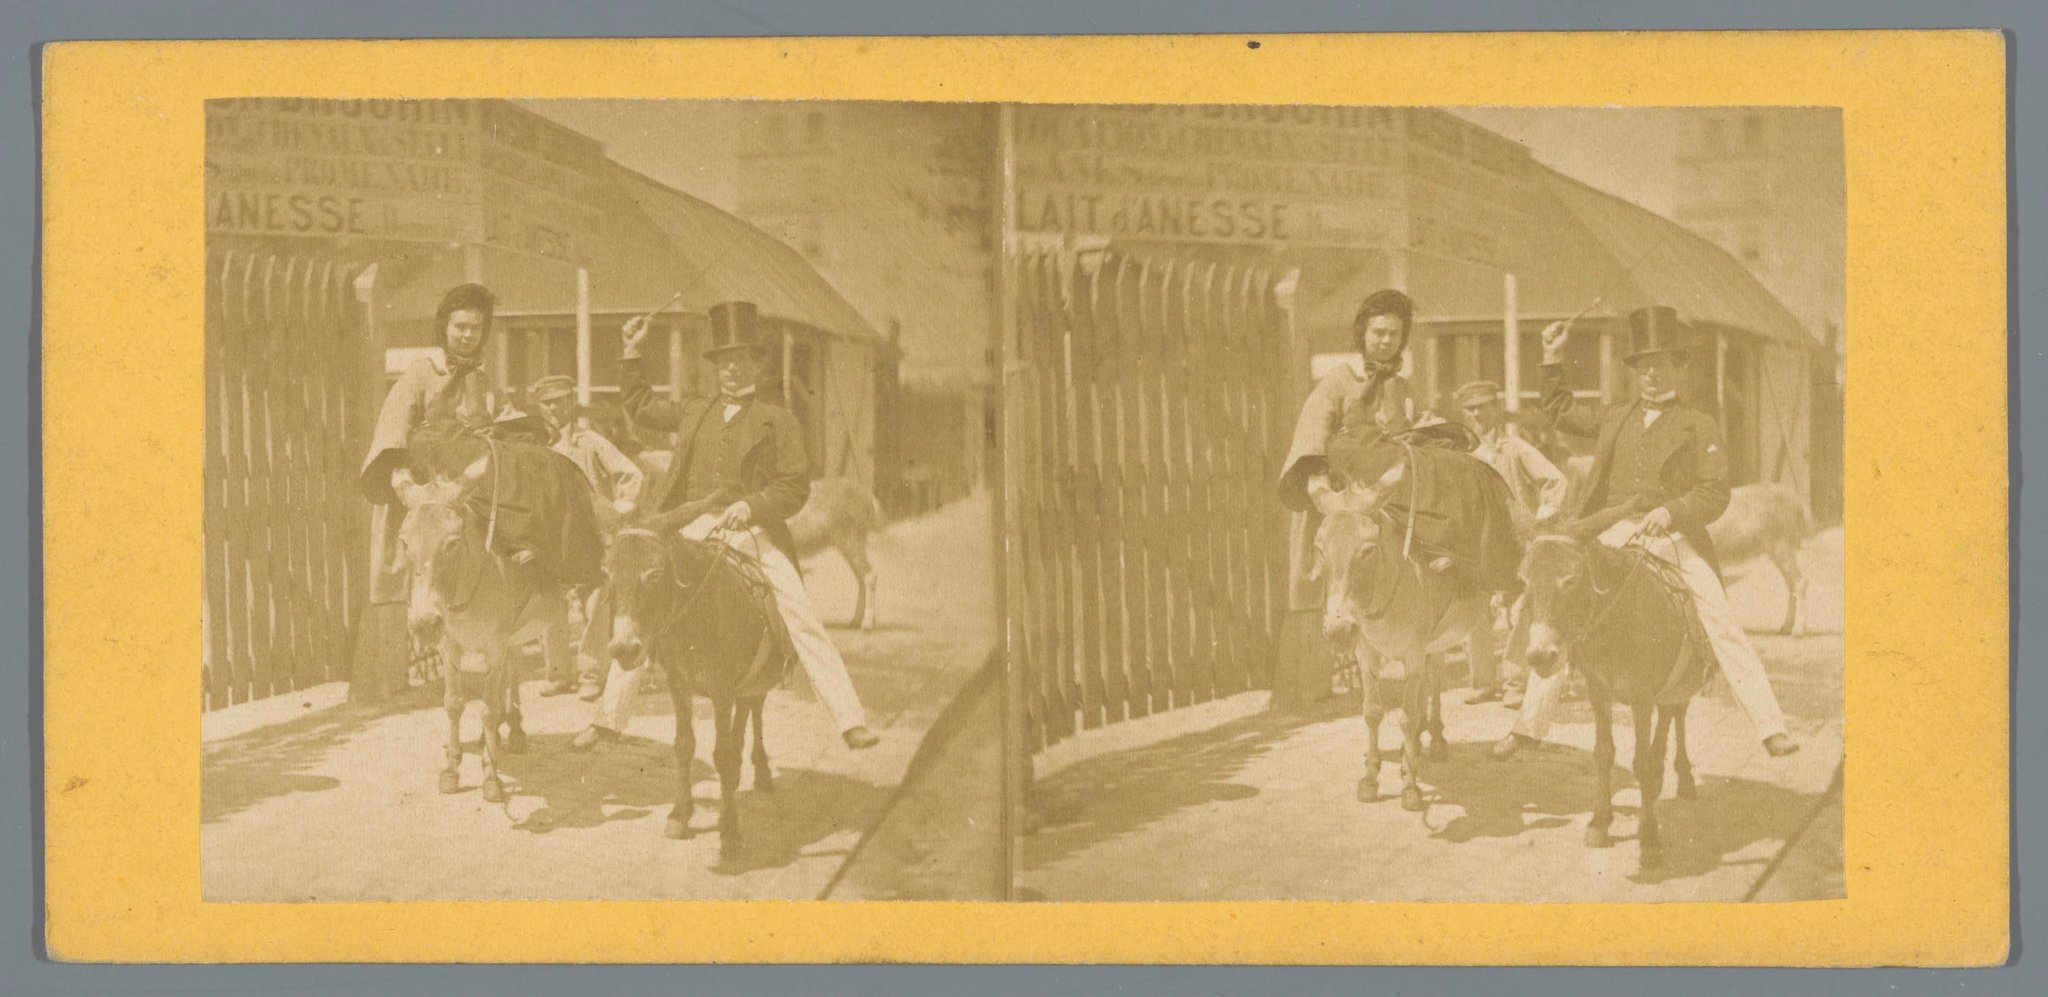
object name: stereograph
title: Man met een hoge hoed en een vrouw rijden op ezels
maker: Anonymous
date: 1850-1880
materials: cardboard, photographic support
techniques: albumen print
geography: france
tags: donkey-riding (on the beach), head-gear: top hat, europe